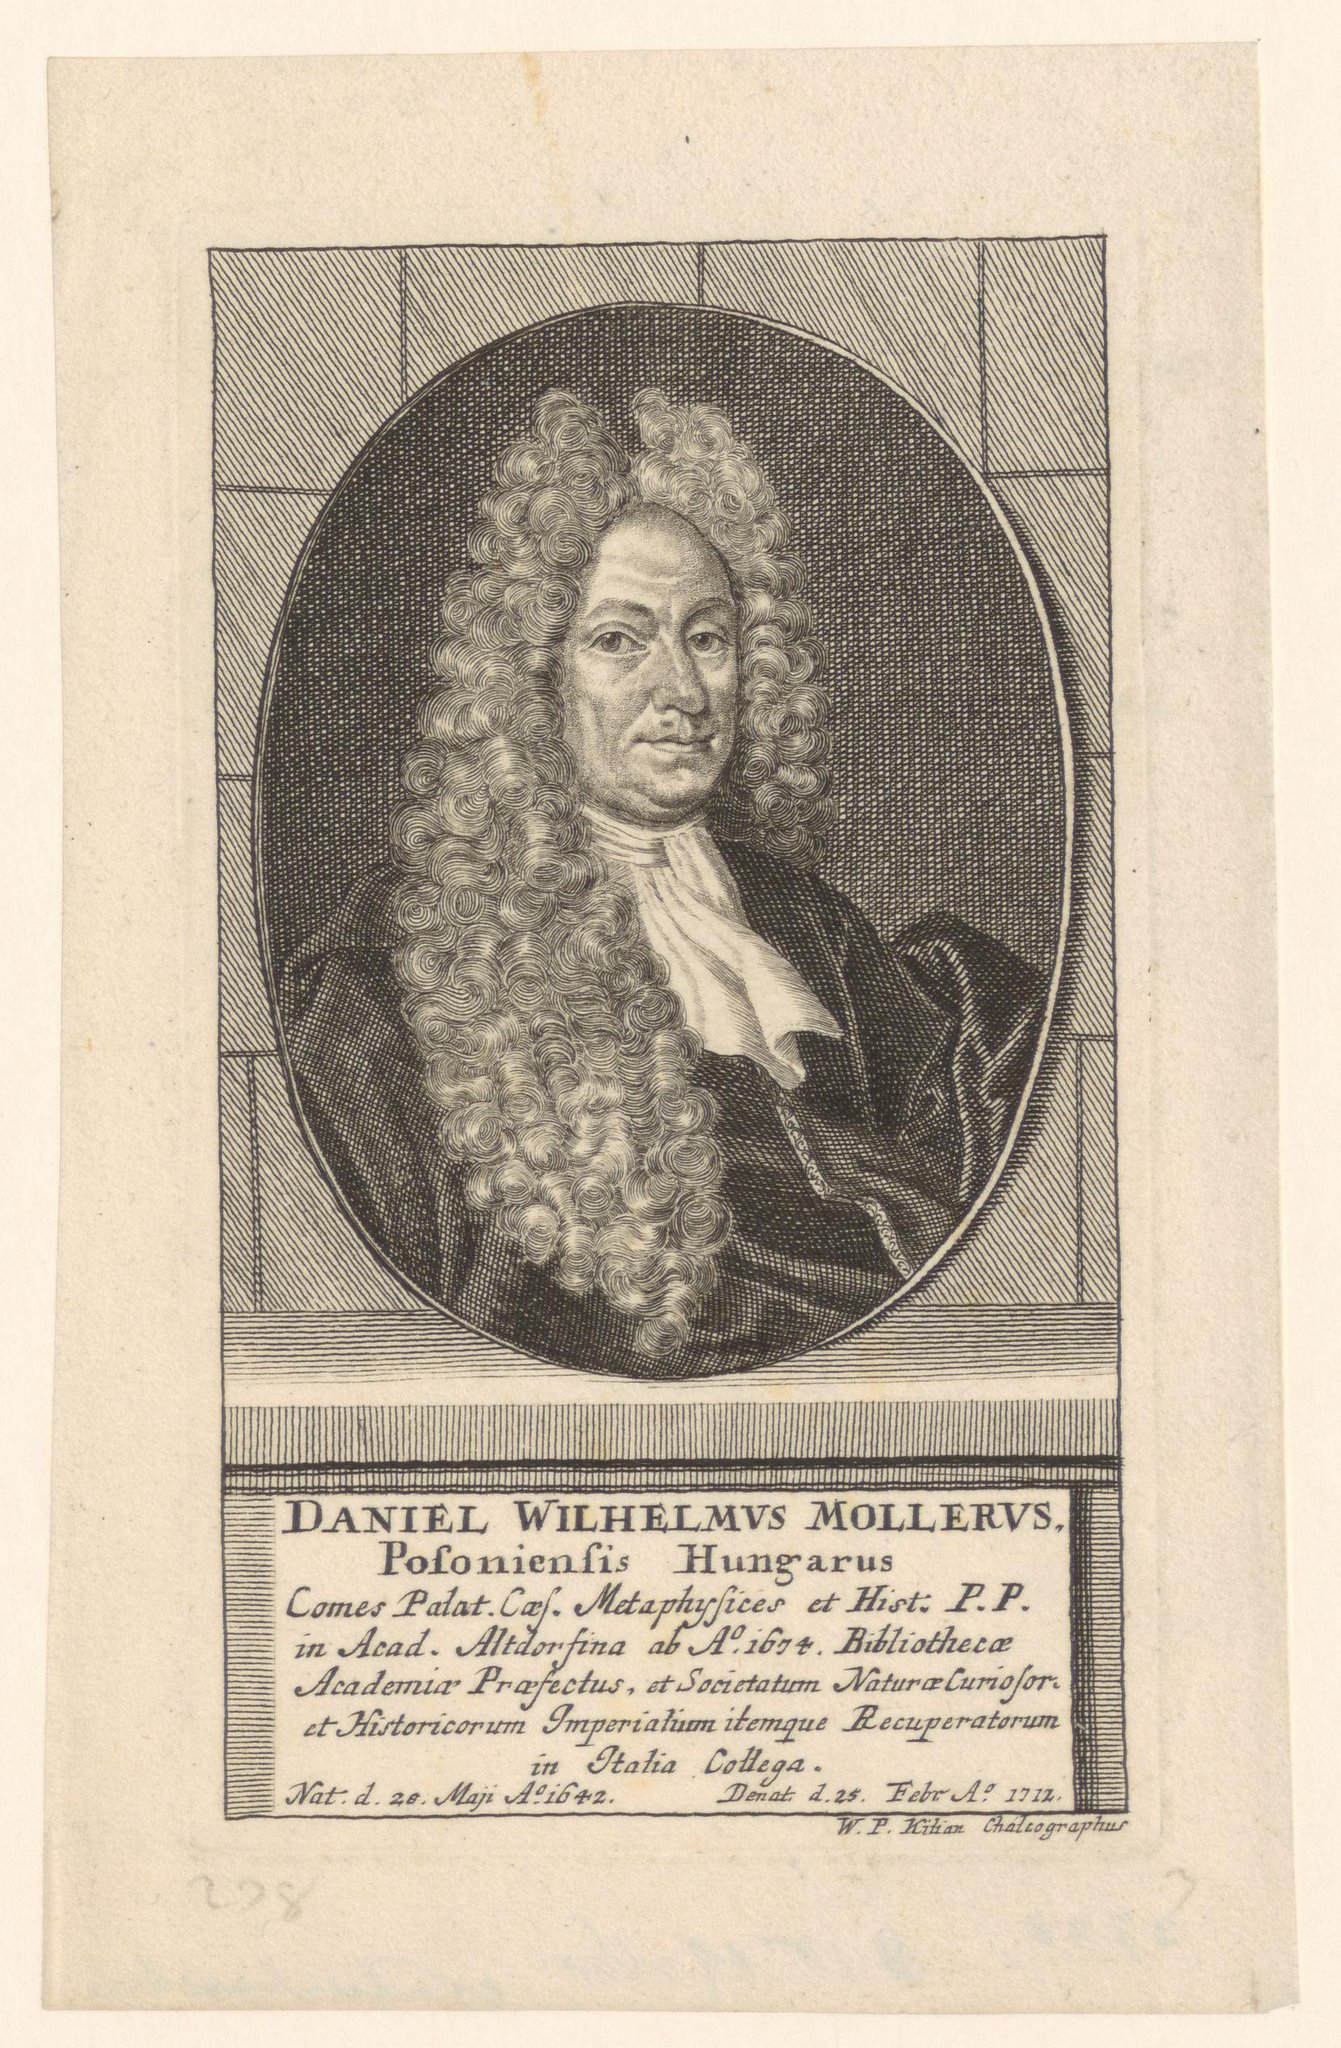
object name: print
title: Portret van Daniel Wilhelm Moller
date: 1712-1728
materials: paper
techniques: engraving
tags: daniel wilhelm moller, history and archaeology (+ portrait of scholar, scientist), further education (+ portrait of teacher, professor), historical persons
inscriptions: collector's mark: Lugt 2228